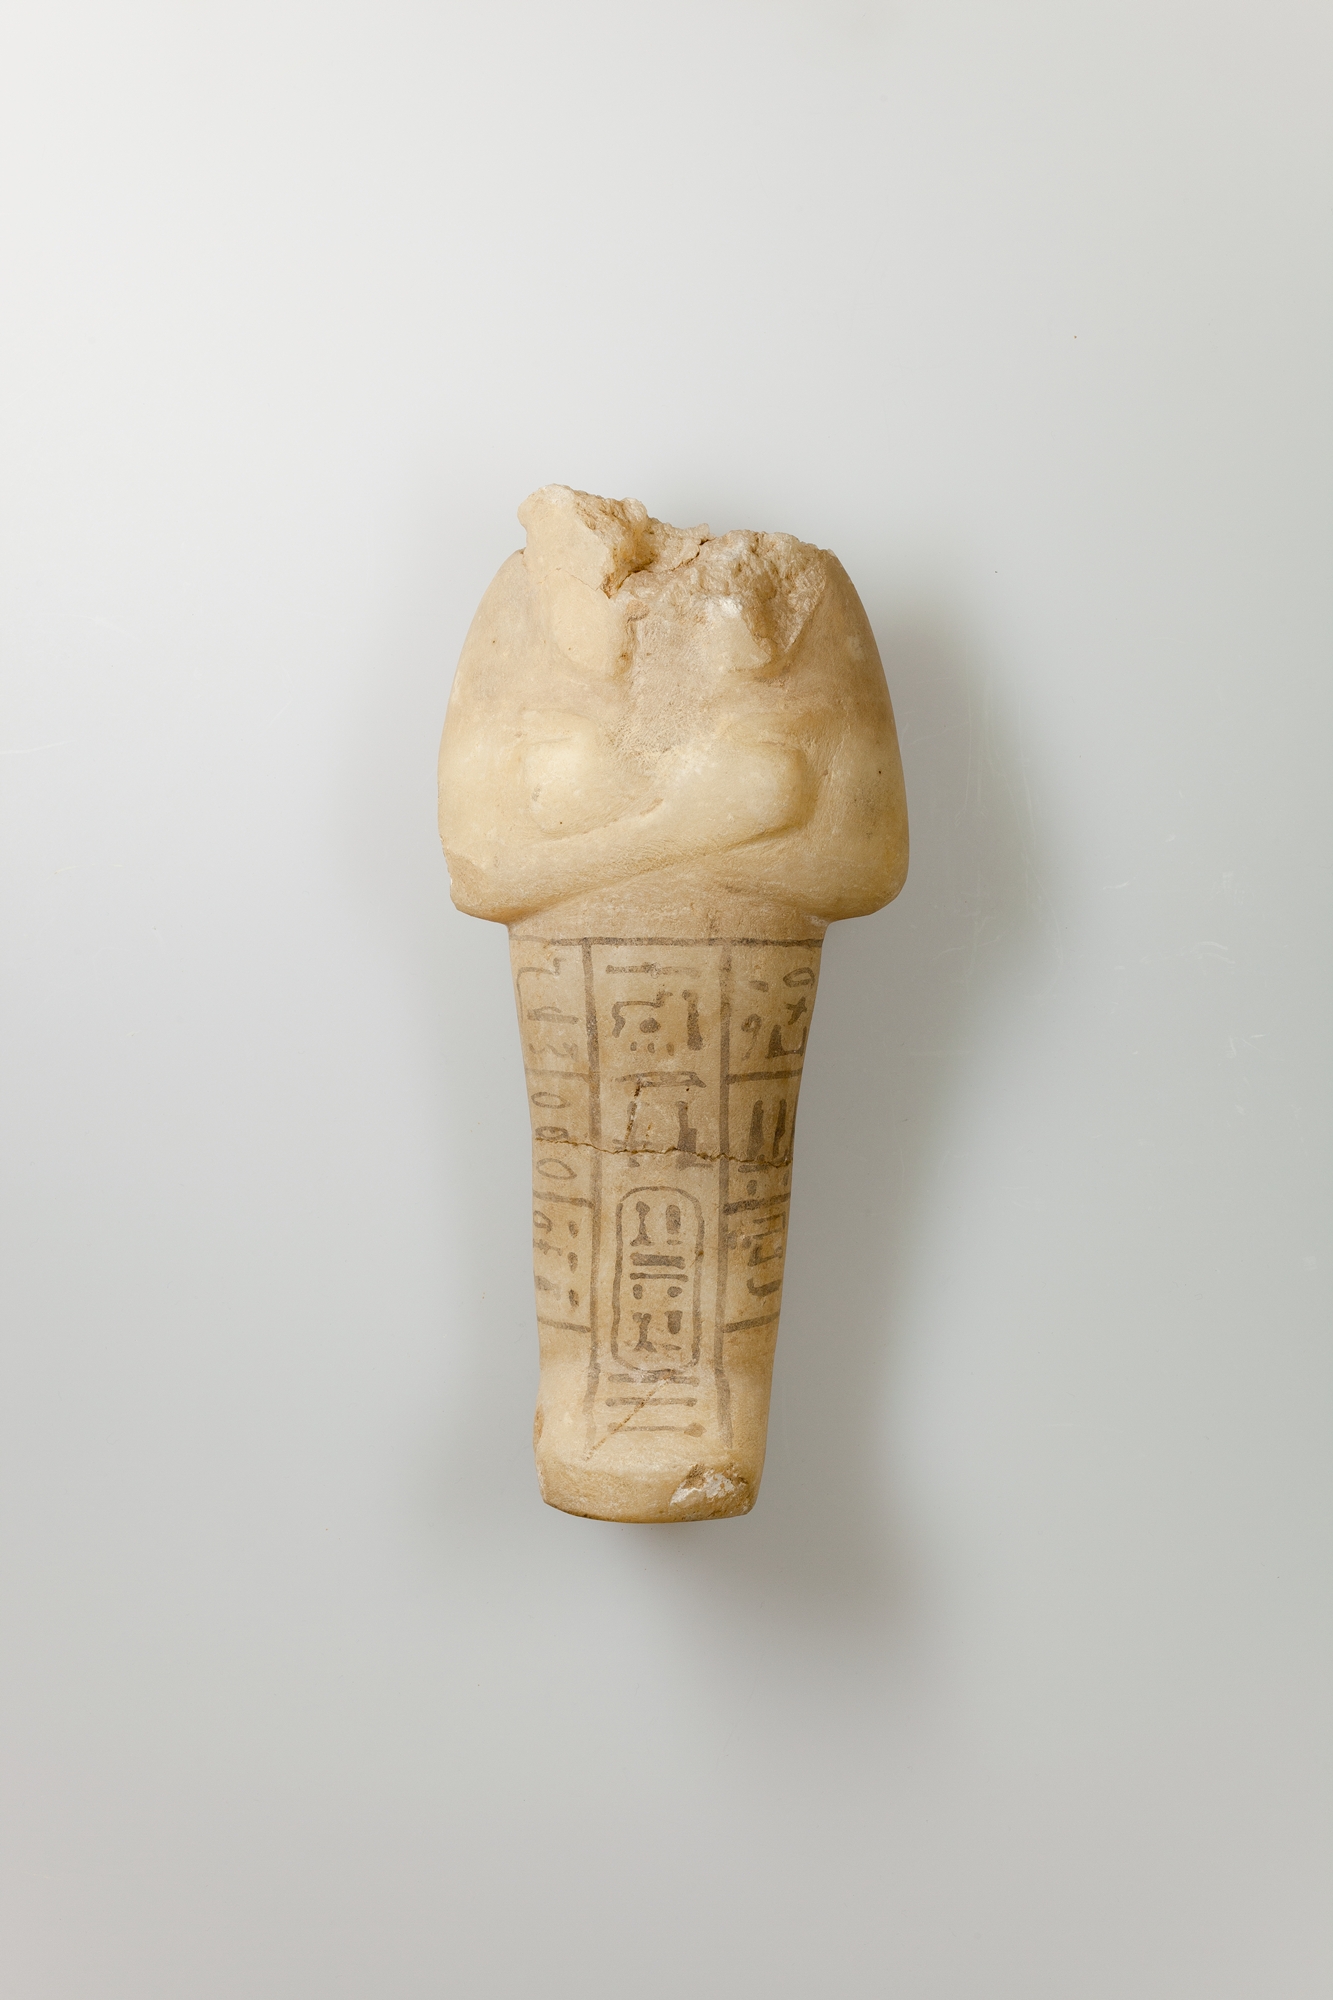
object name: shabti, siptah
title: Shabti of Siptah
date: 1194-1188 BCE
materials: stone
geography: egypt